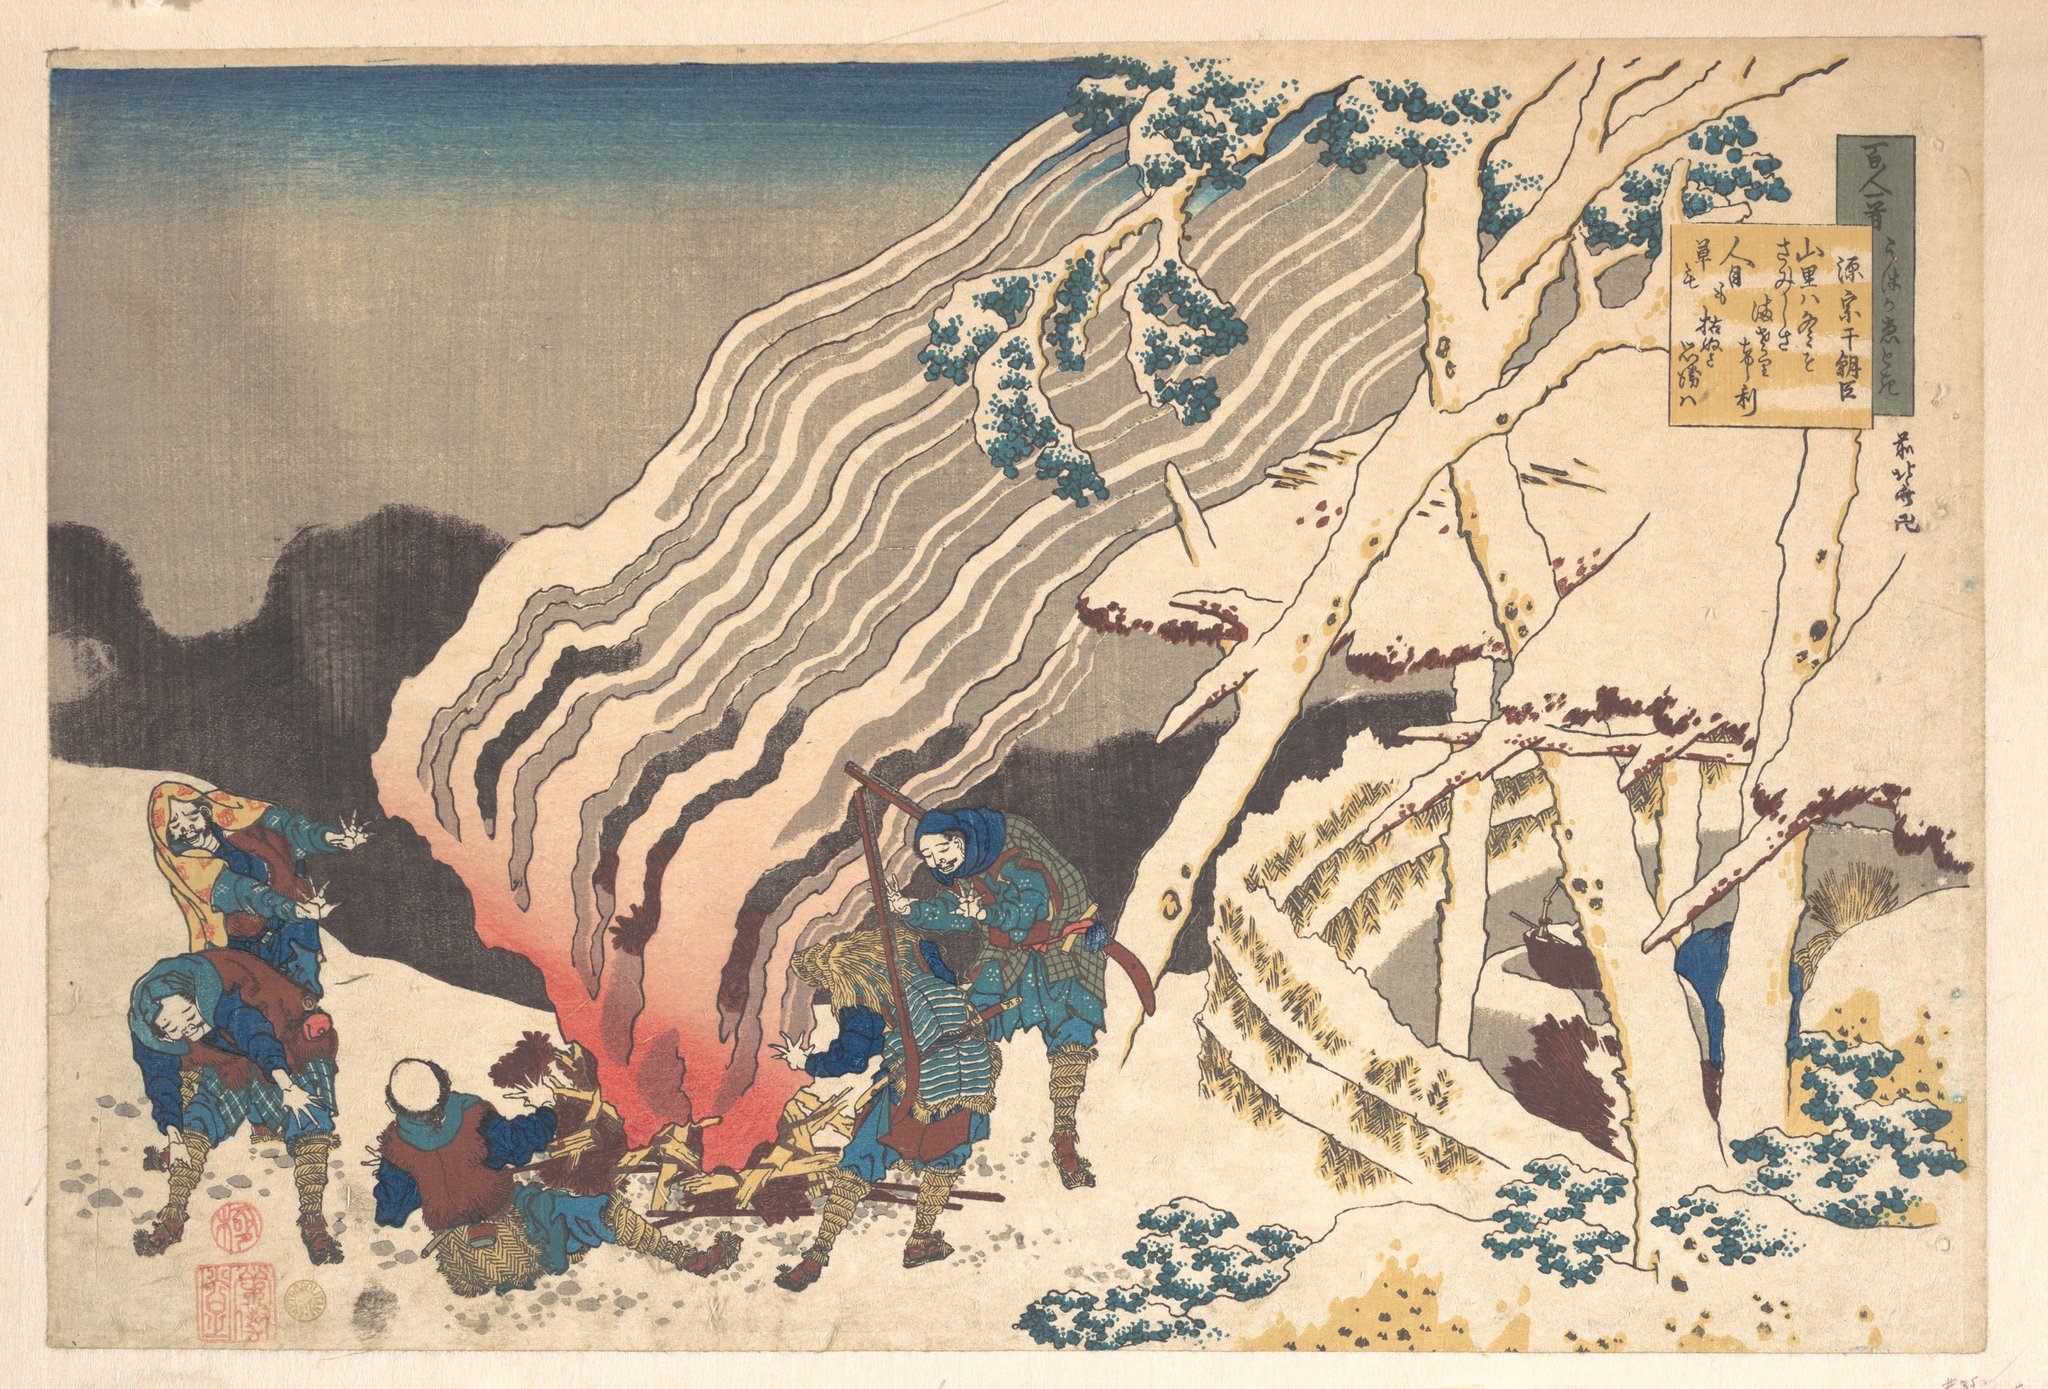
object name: woodblock print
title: Poem by Minamoto no Muneyuki Ason, from the series One Hundred Poems Explained by the Nurse (Hyakunin isshu uba ga etoki)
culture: japanese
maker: katsushika hokusai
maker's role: artist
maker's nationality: japanese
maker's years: 1760-1849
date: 1839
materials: ink, paper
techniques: woodblock print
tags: poetry,suffering,hills,trees,snow